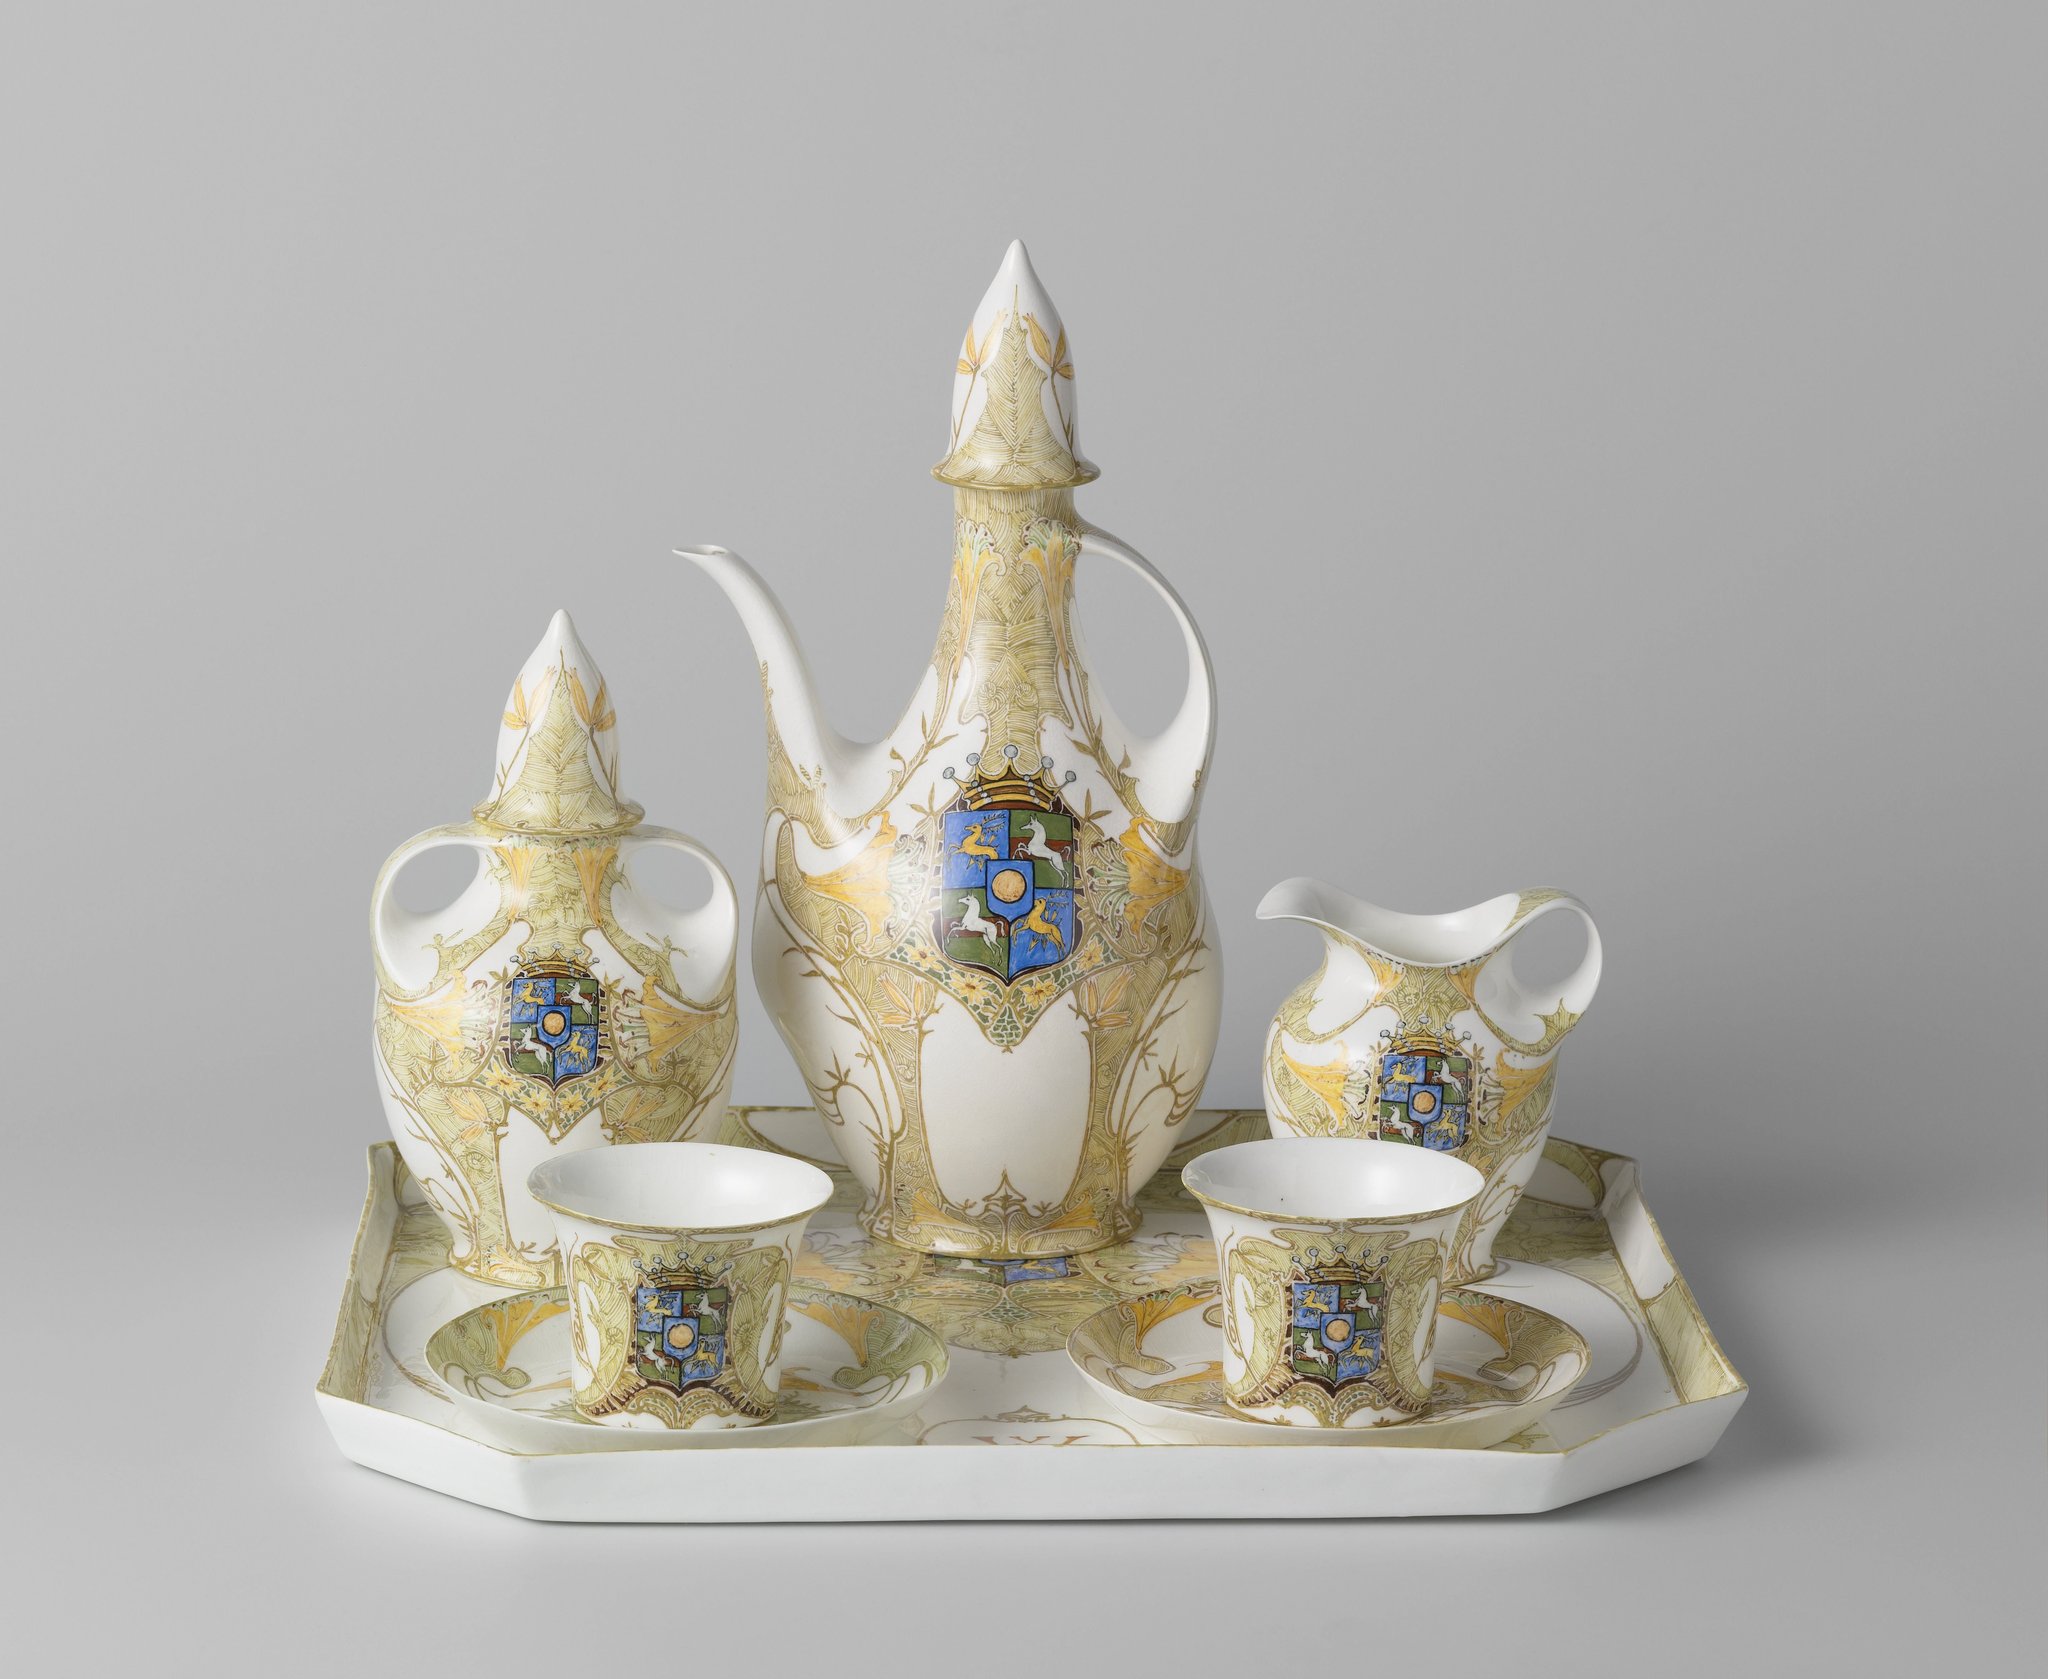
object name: tête à tête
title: Tête-à-tête, bestaande uit verschillende delen en beschilderd met lelies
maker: jacob willem van rossum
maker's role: print maker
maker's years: 1881-1963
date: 1900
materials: porcelain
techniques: painted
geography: the hague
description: Tea service with the arms of Baron Louis P.M.H. Michiels van Verduynen 1900, decorated by Jacobus Willem van Rossum, model nos 118 (tea pot), 119 (milk jug), 120 (sugar bowl), 123 (cup).